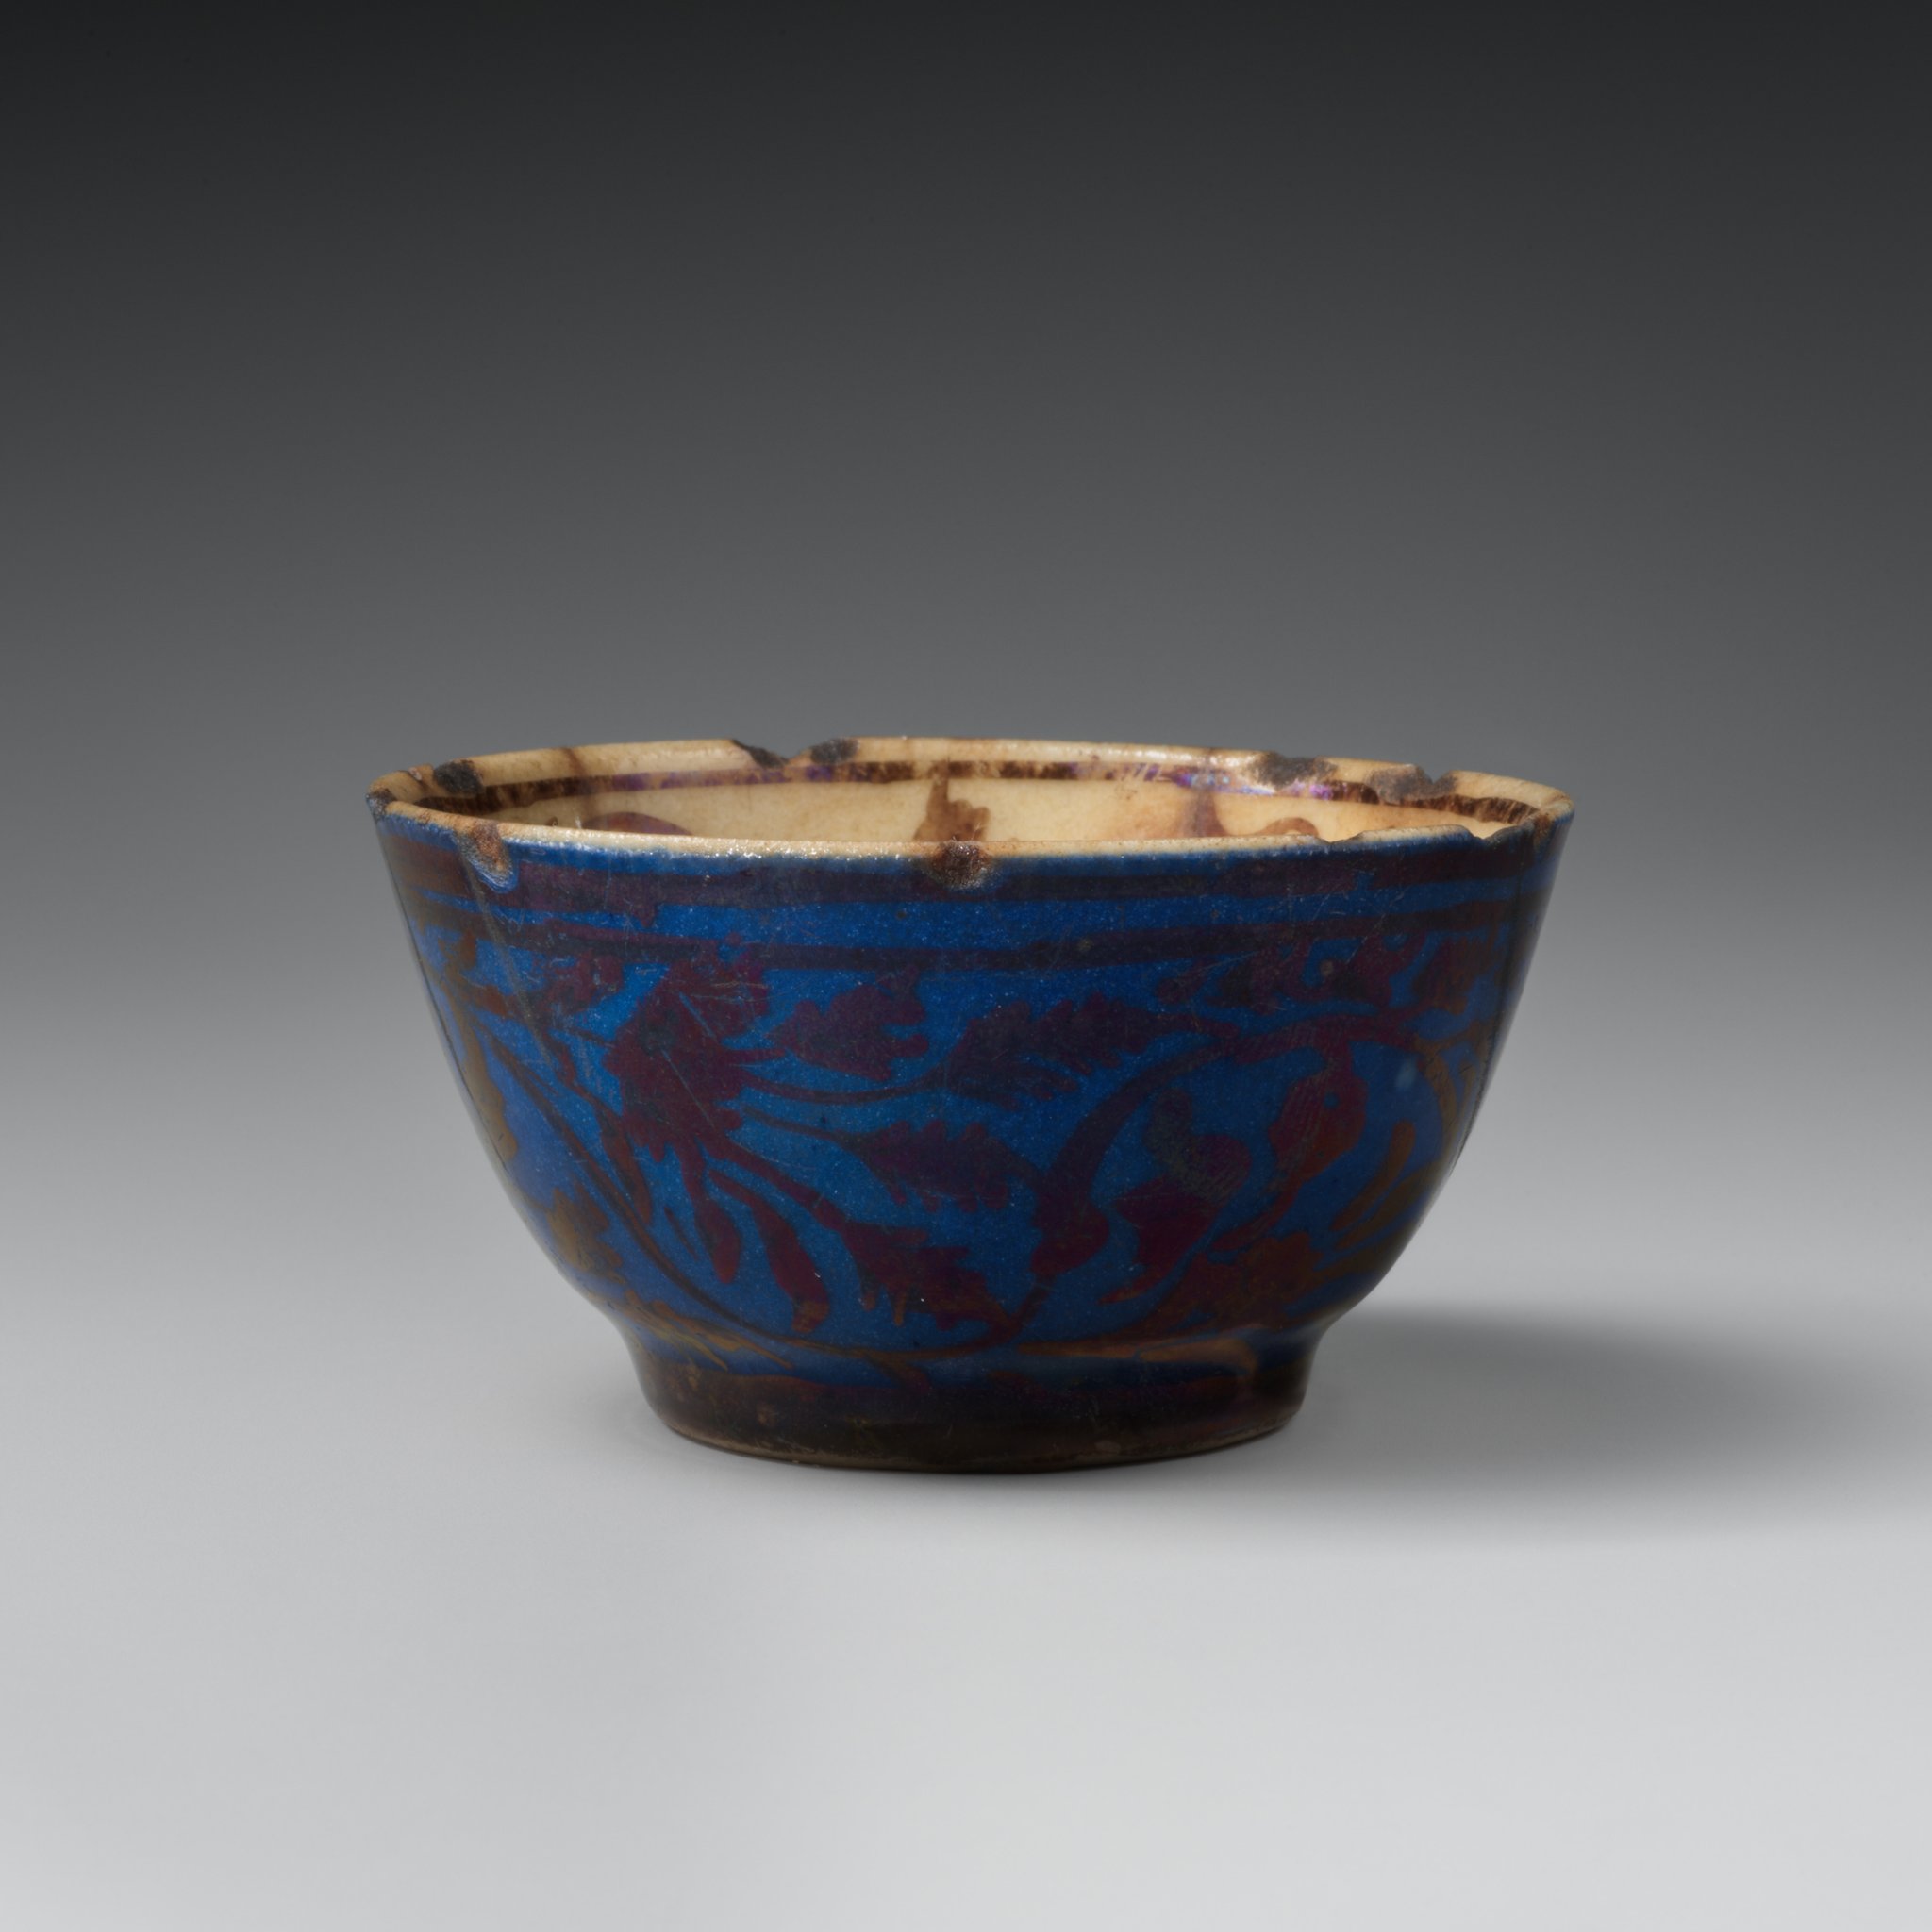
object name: cup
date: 1601-1700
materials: glaze, stonepaste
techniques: luster painting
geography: iran